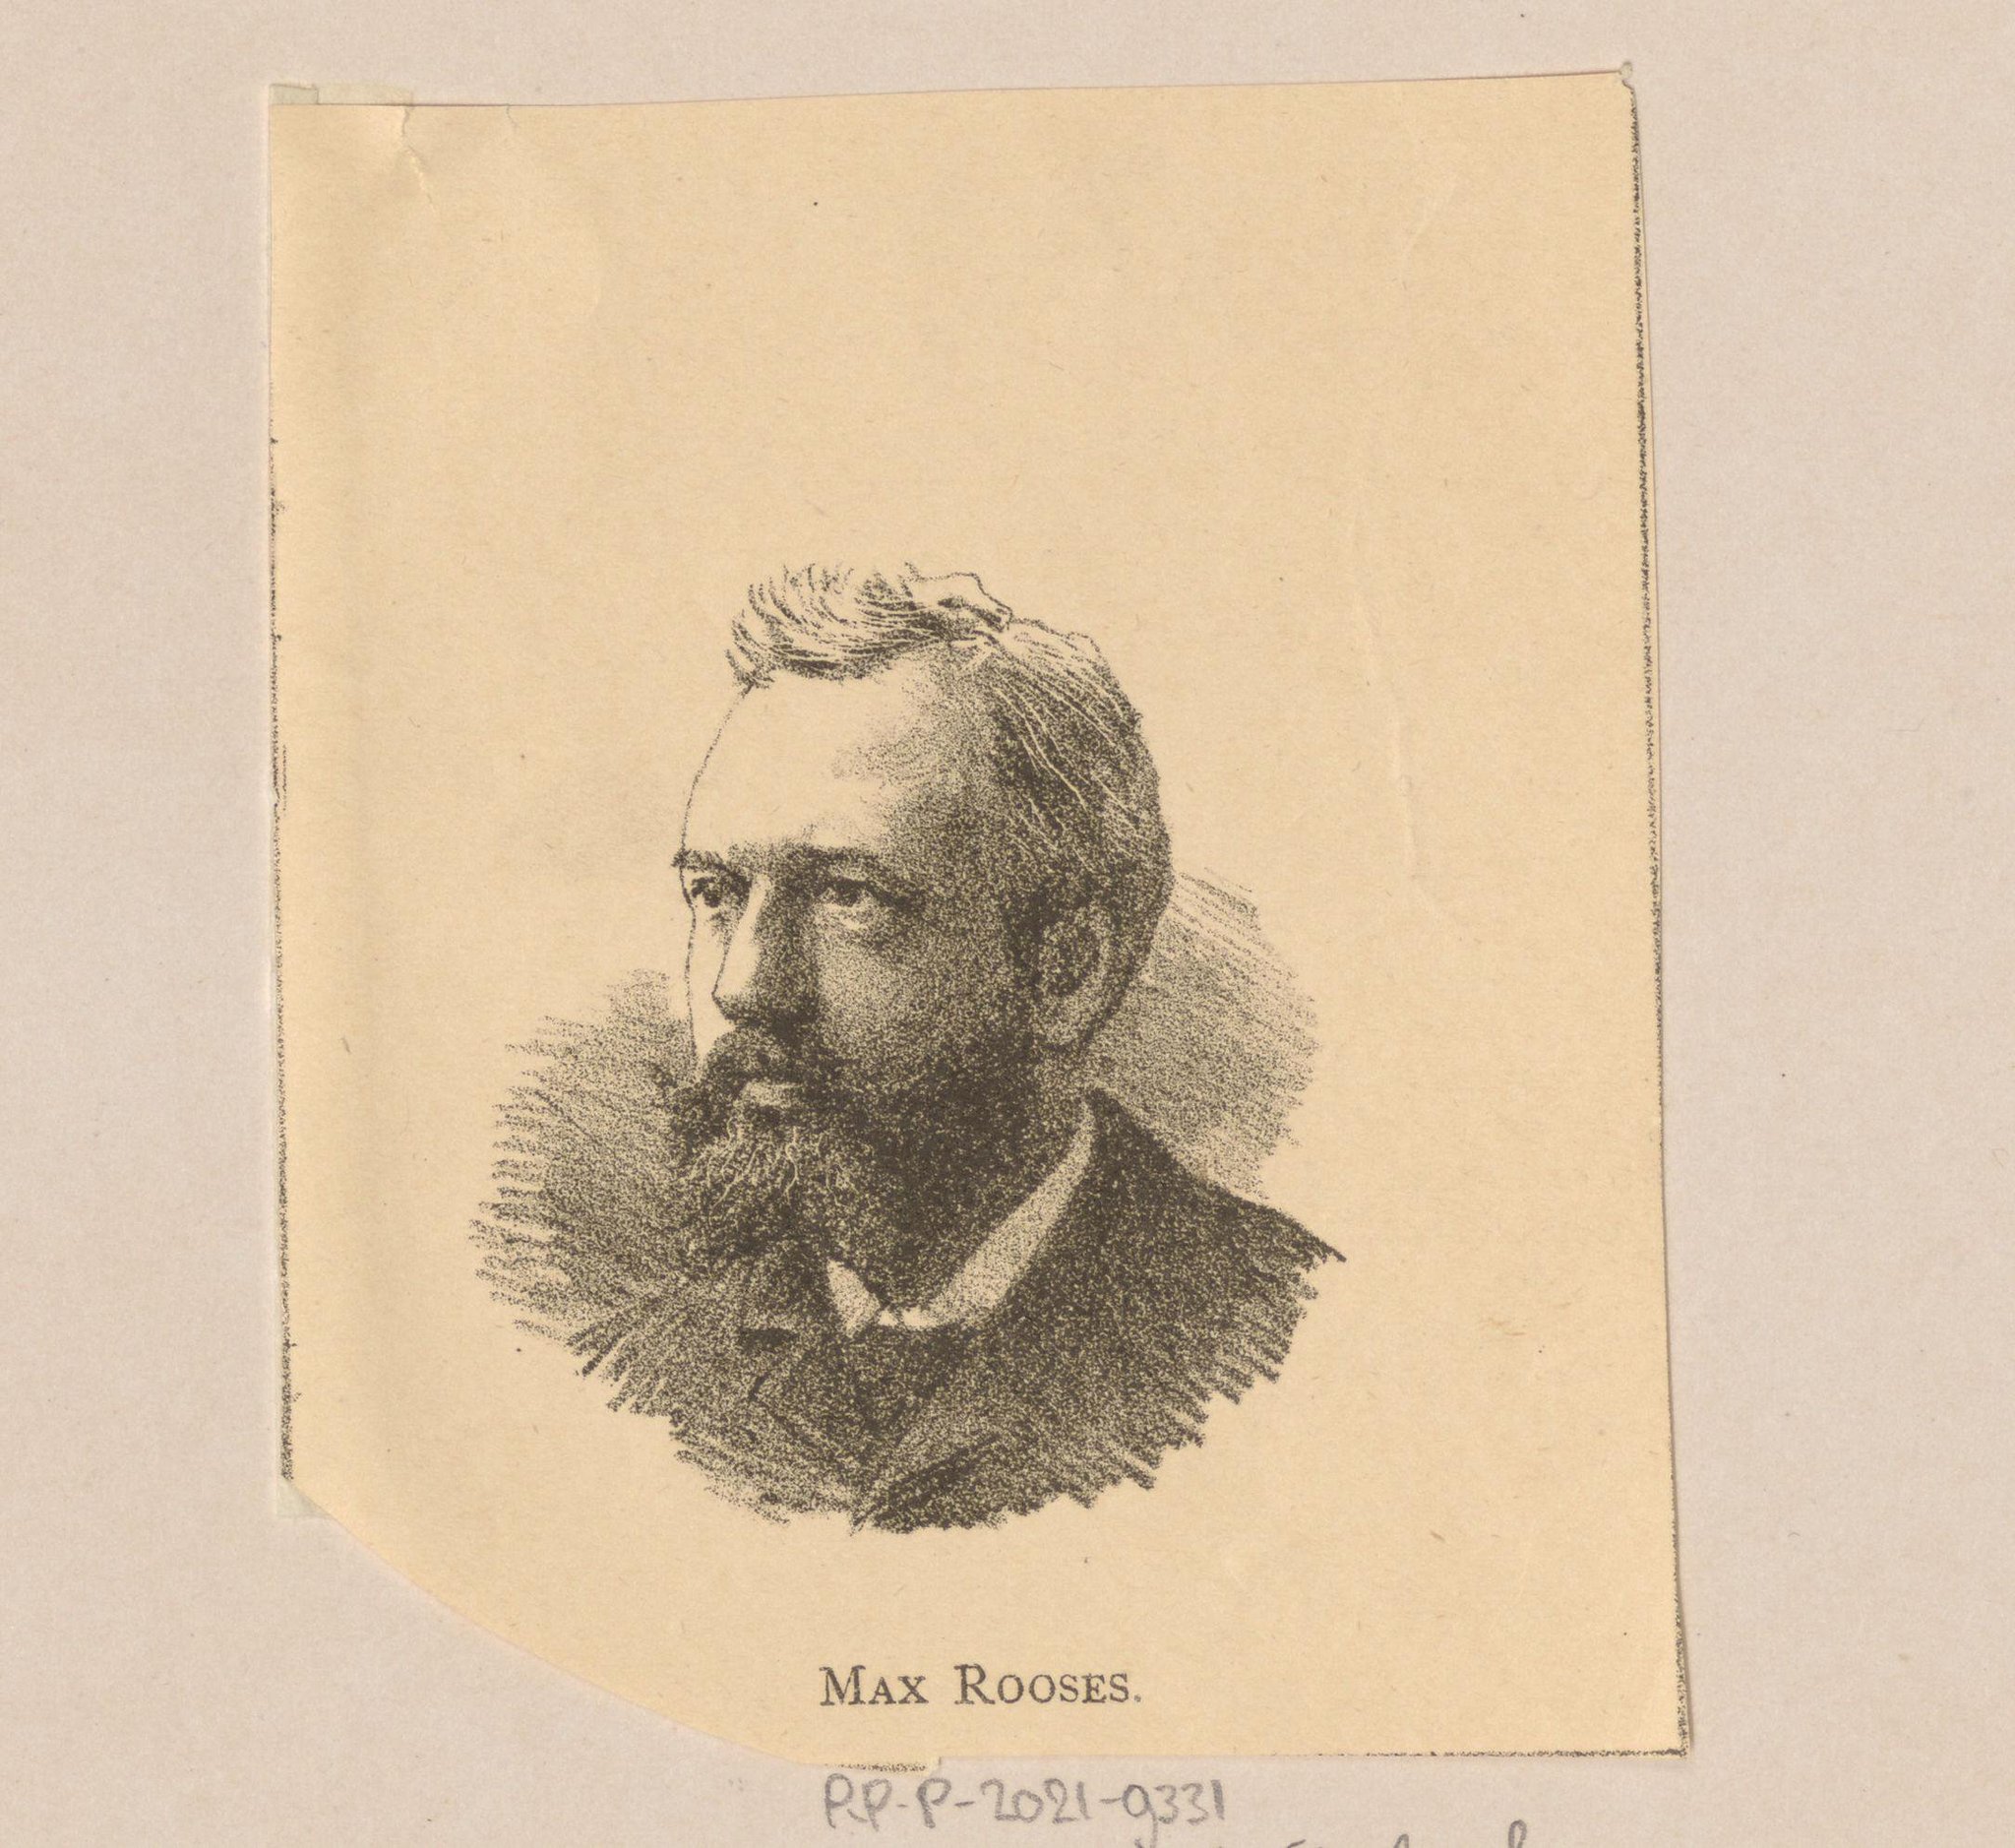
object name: print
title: Portret van Max Rooses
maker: willem steelink (i)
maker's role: draughtsman, print maker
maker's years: 1826-1913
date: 1879-1913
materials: paper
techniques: lithograph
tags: antwerp, max rooses, historical persons